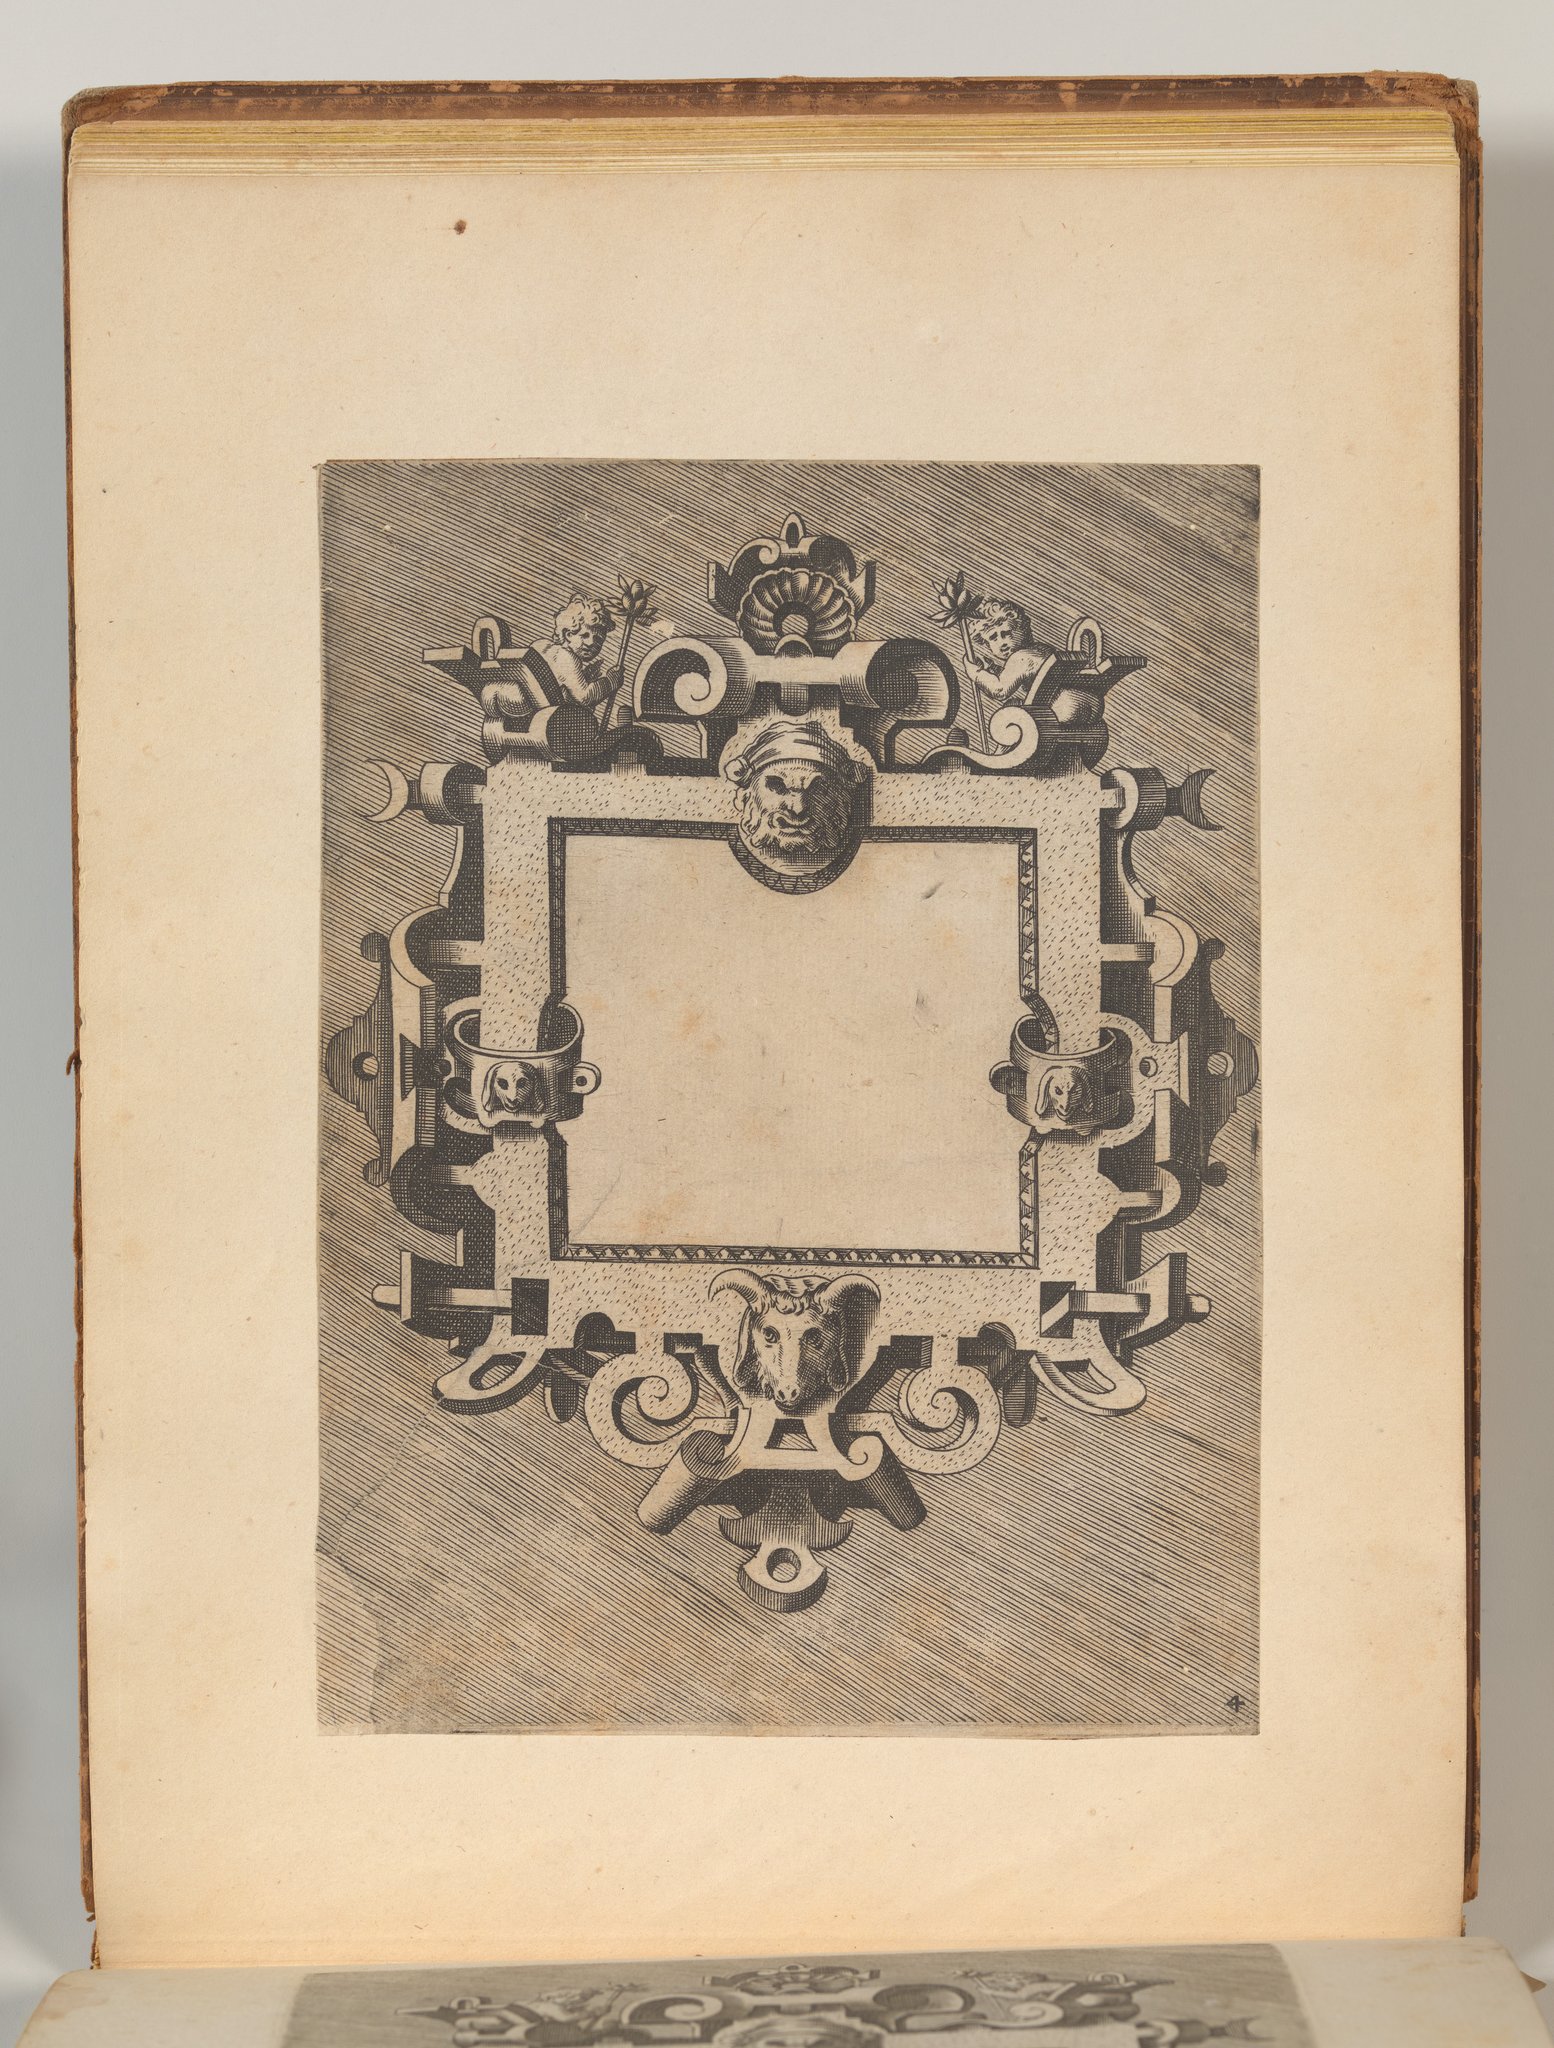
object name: album print ornament architecture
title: Targhe ed altri ornati di varie e capricciose invenzioni (Cartouches and other ornaments of various and capricious invention, page 32)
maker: hans vredeman de vries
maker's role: artist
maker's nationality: netherlandish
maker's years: 1527-1606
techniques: engraving, etching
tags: masks,cartouches,ornament